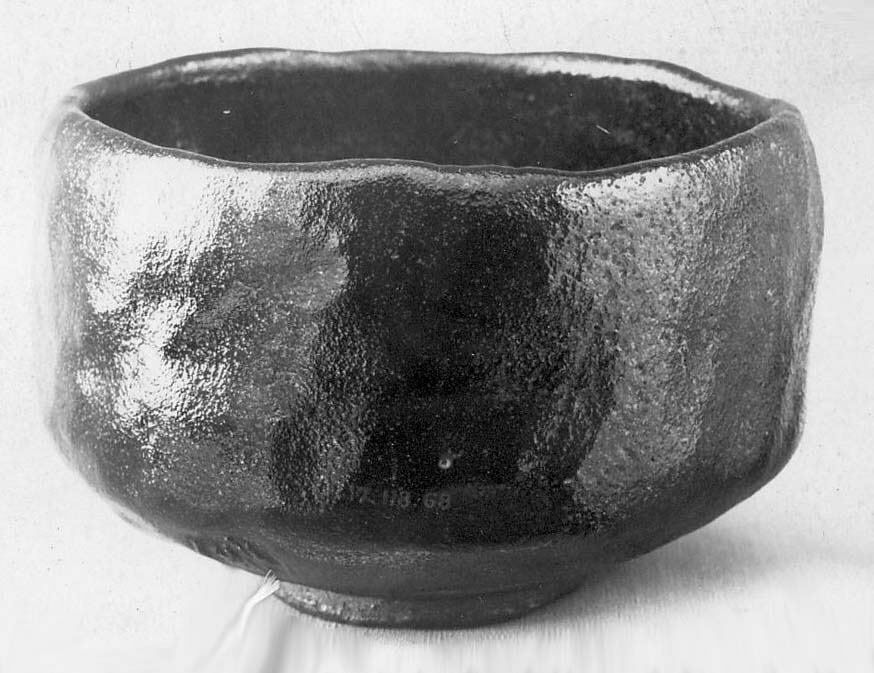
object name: teabowl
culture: japanese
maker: raku chōnyū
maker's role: artist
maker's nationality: japanese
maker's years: 1714-1770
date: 1750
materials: clay, glaze